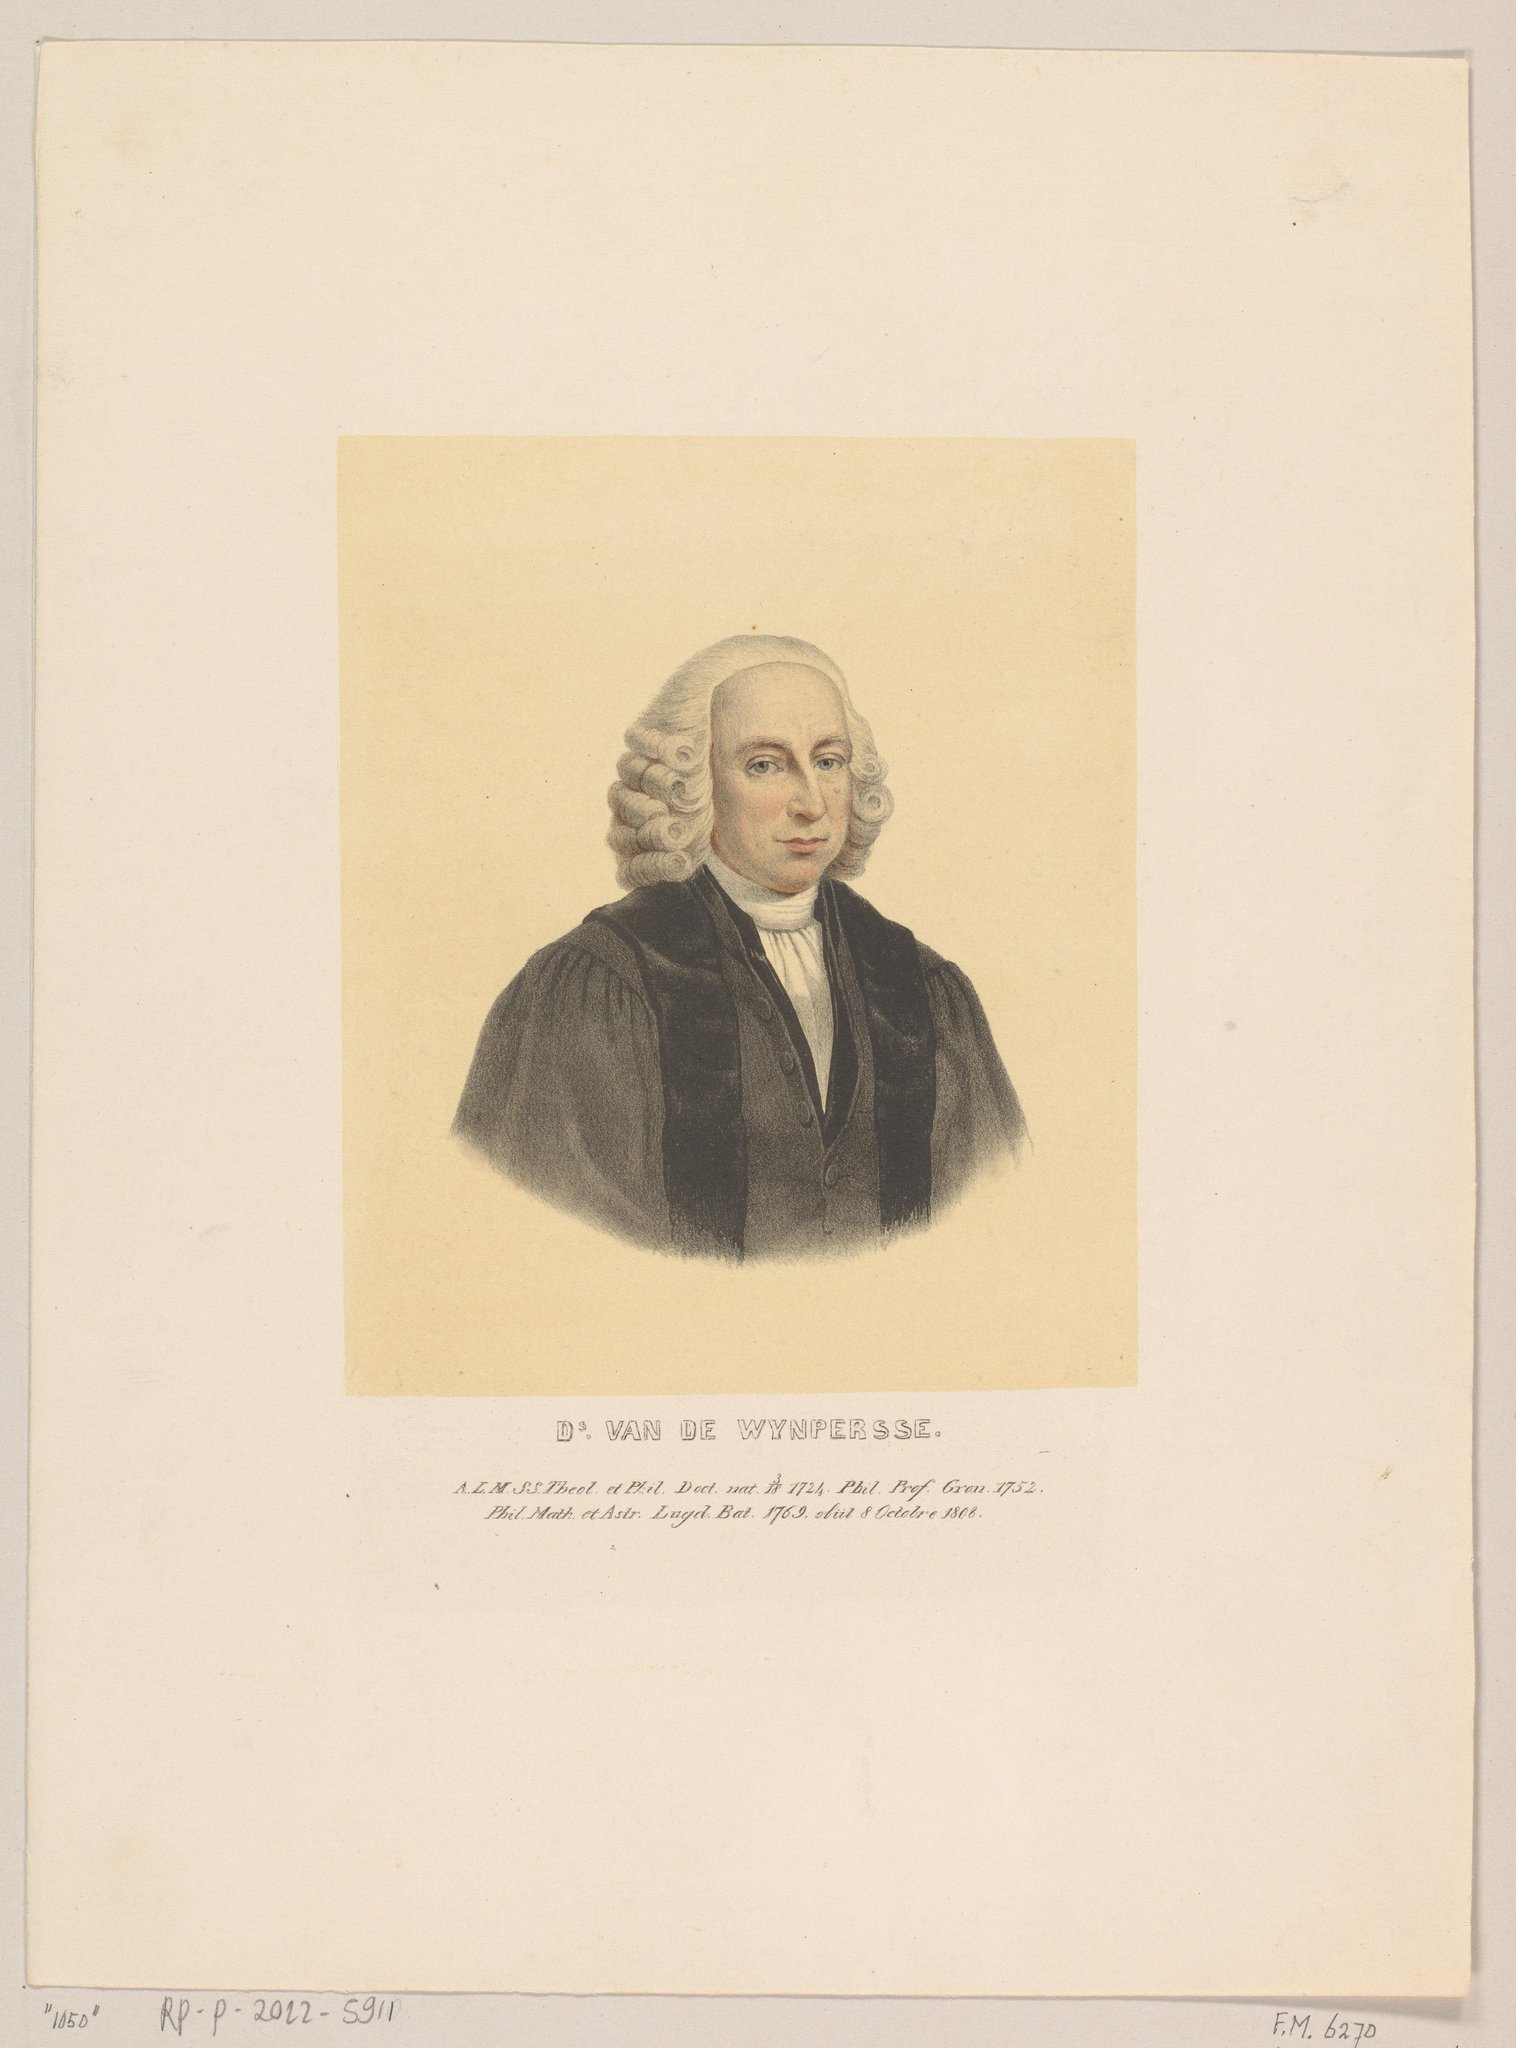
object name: book illustration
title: Portret van Dionysius van de Wijnpersse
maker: leendert springer (i)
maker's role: draughtsman, painter, print maker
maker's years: 1789-1871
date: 1845-1850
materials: paper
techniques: lithograph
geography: netherlands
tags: historical persons, professor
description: Prent waarschijnlijk uit: Springer, Leendert. Galerij van hoogleeraren aan de Hoogeschool te Leijden, naar de oorspronkelijke afbeeldsels op de Senaat-zaal aldaar berustende. Leiden: Leendert Springer, s.a. [circa 1850].